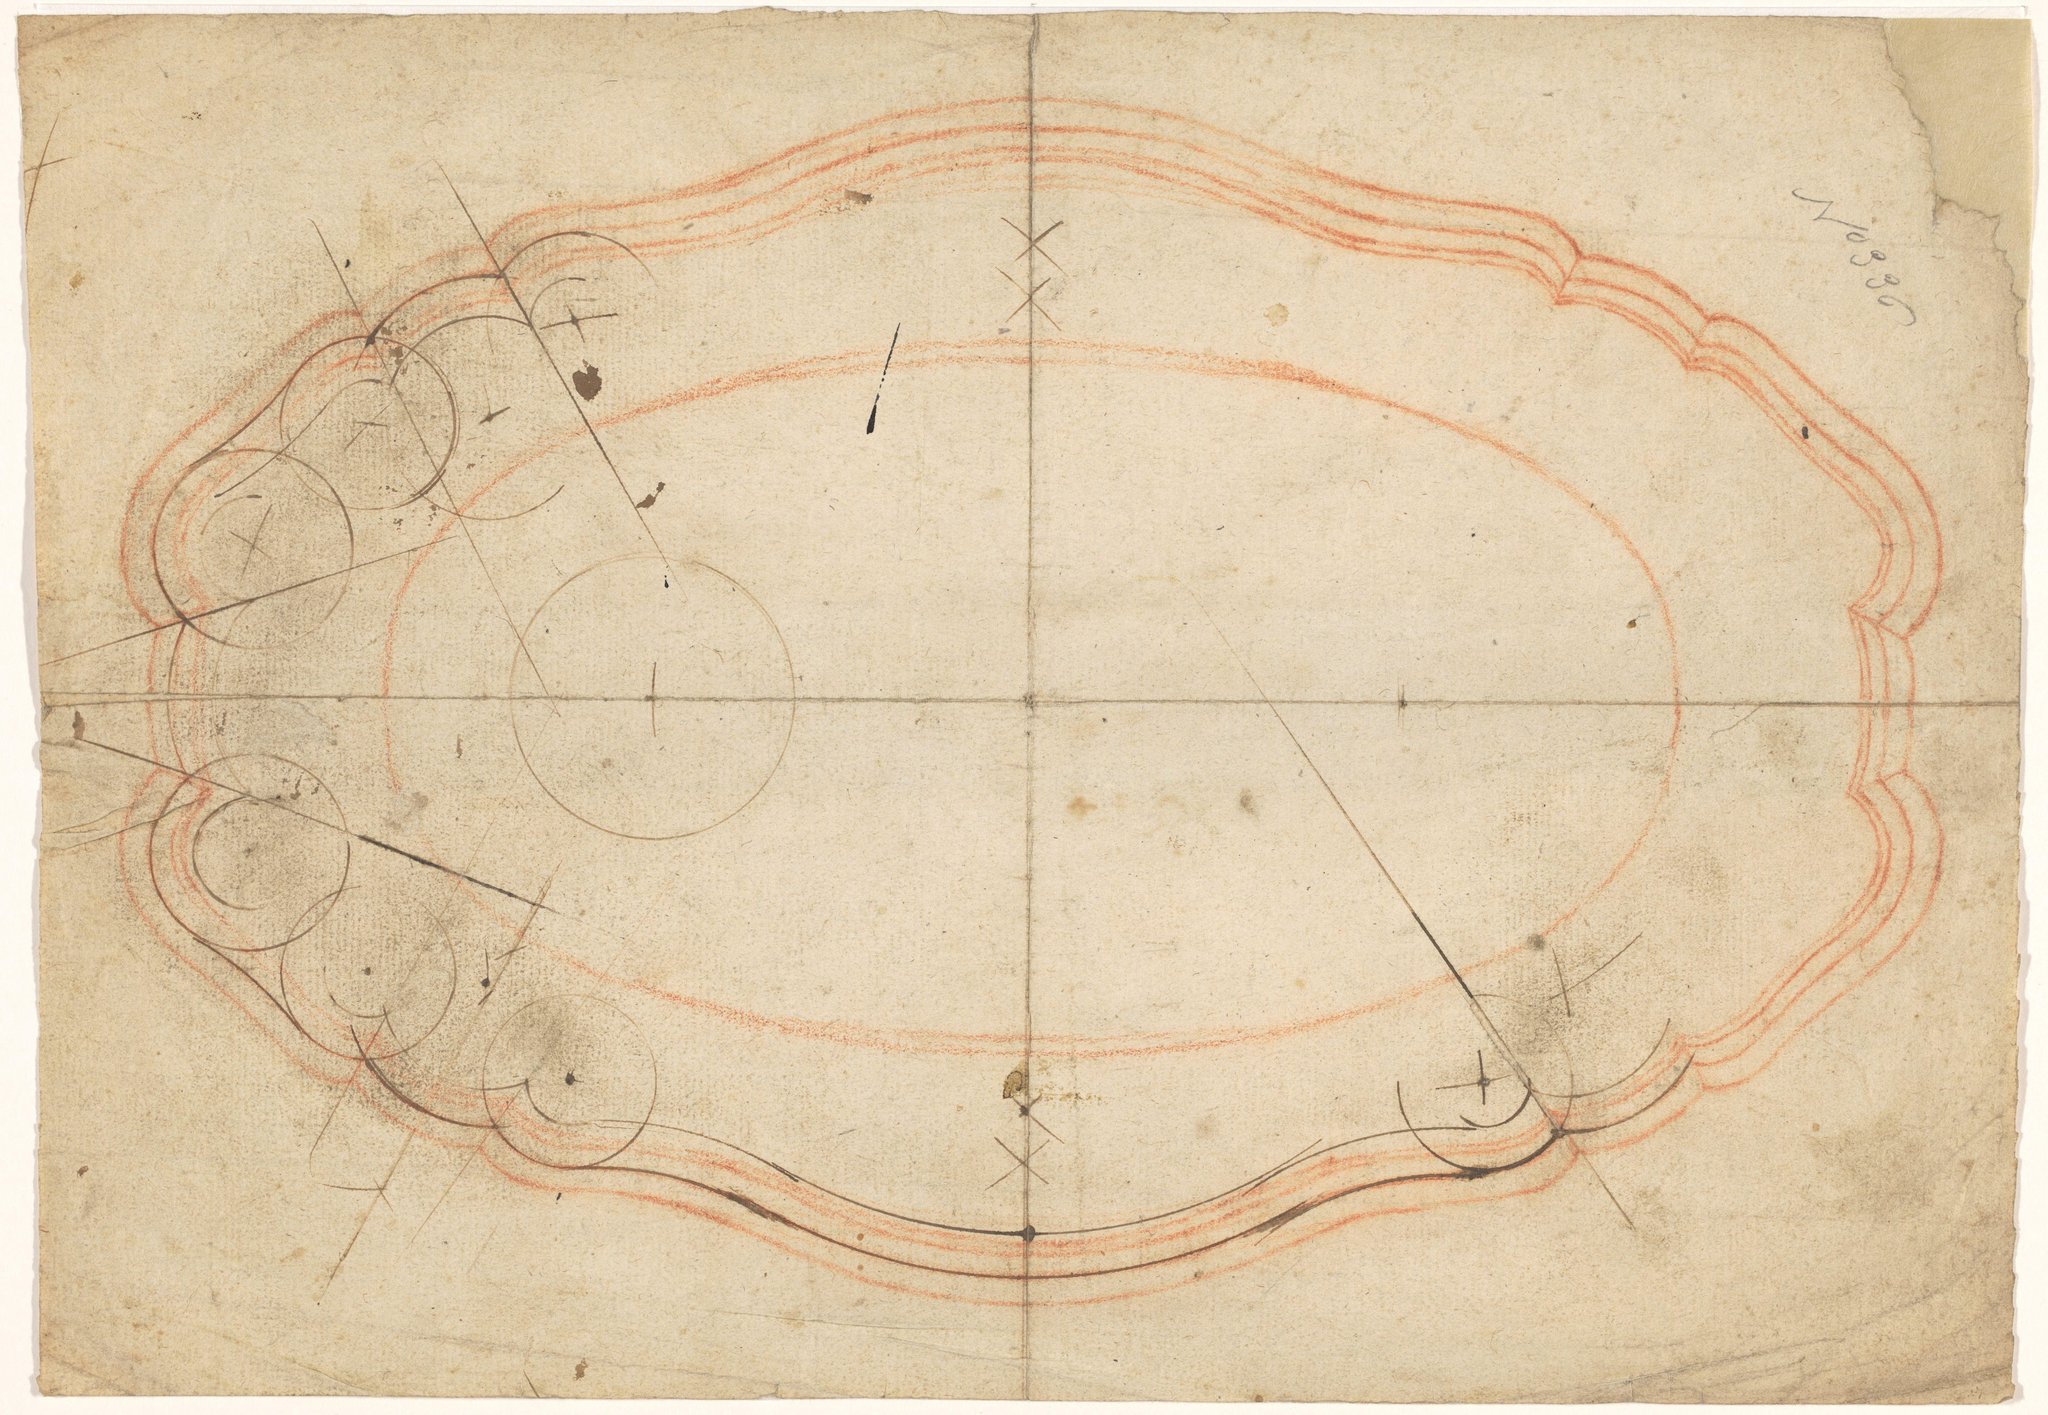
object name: design drawing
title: Ontwerp voor een schaal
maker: Anonymous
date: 1730-1750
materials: chalk, ink, paper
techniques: pen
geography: paris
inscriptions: number: ‘No 336’, watermark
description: De tekening is op bruin papier opgeplakt, waarop een schets in grafiet van een bladertakje.